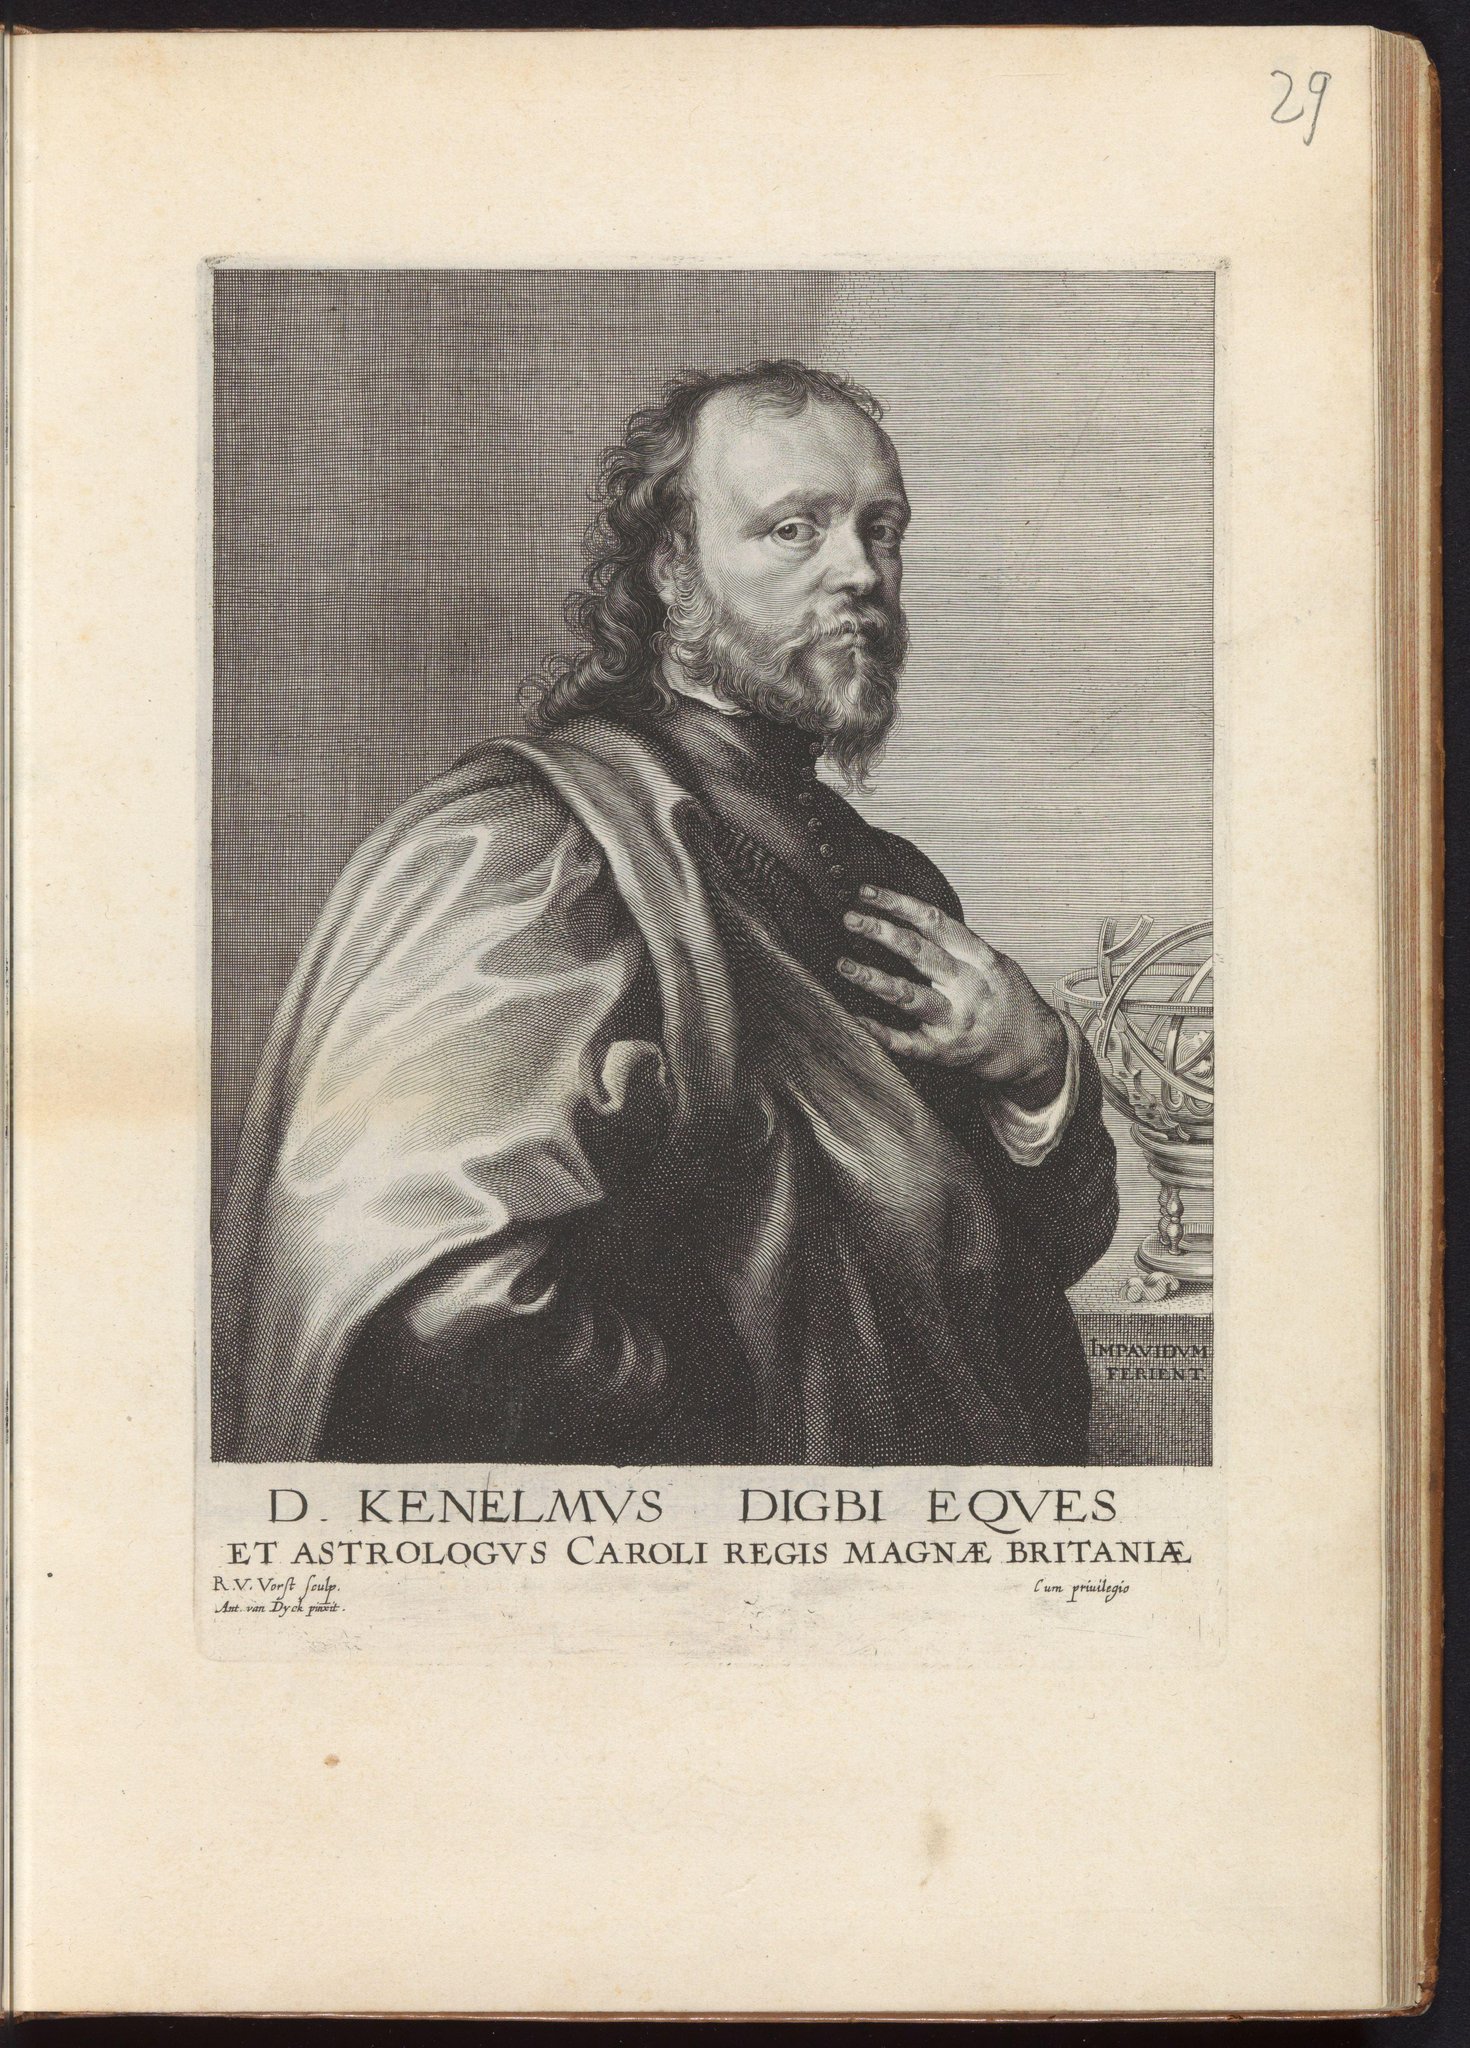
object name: print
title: Portret van Kenelm Digby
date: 1630-1641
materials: paper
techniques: engraving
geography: antwerp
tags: london, physicist, armillary sphere, skeleton celestial globe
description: Portet van de zeeofficier en diplomaat Kenelm Digby. Op de tafel staat een armillarium, die verwijst naar zijn interesse voor astronomie. Deze prent maakt deel uit van een album.